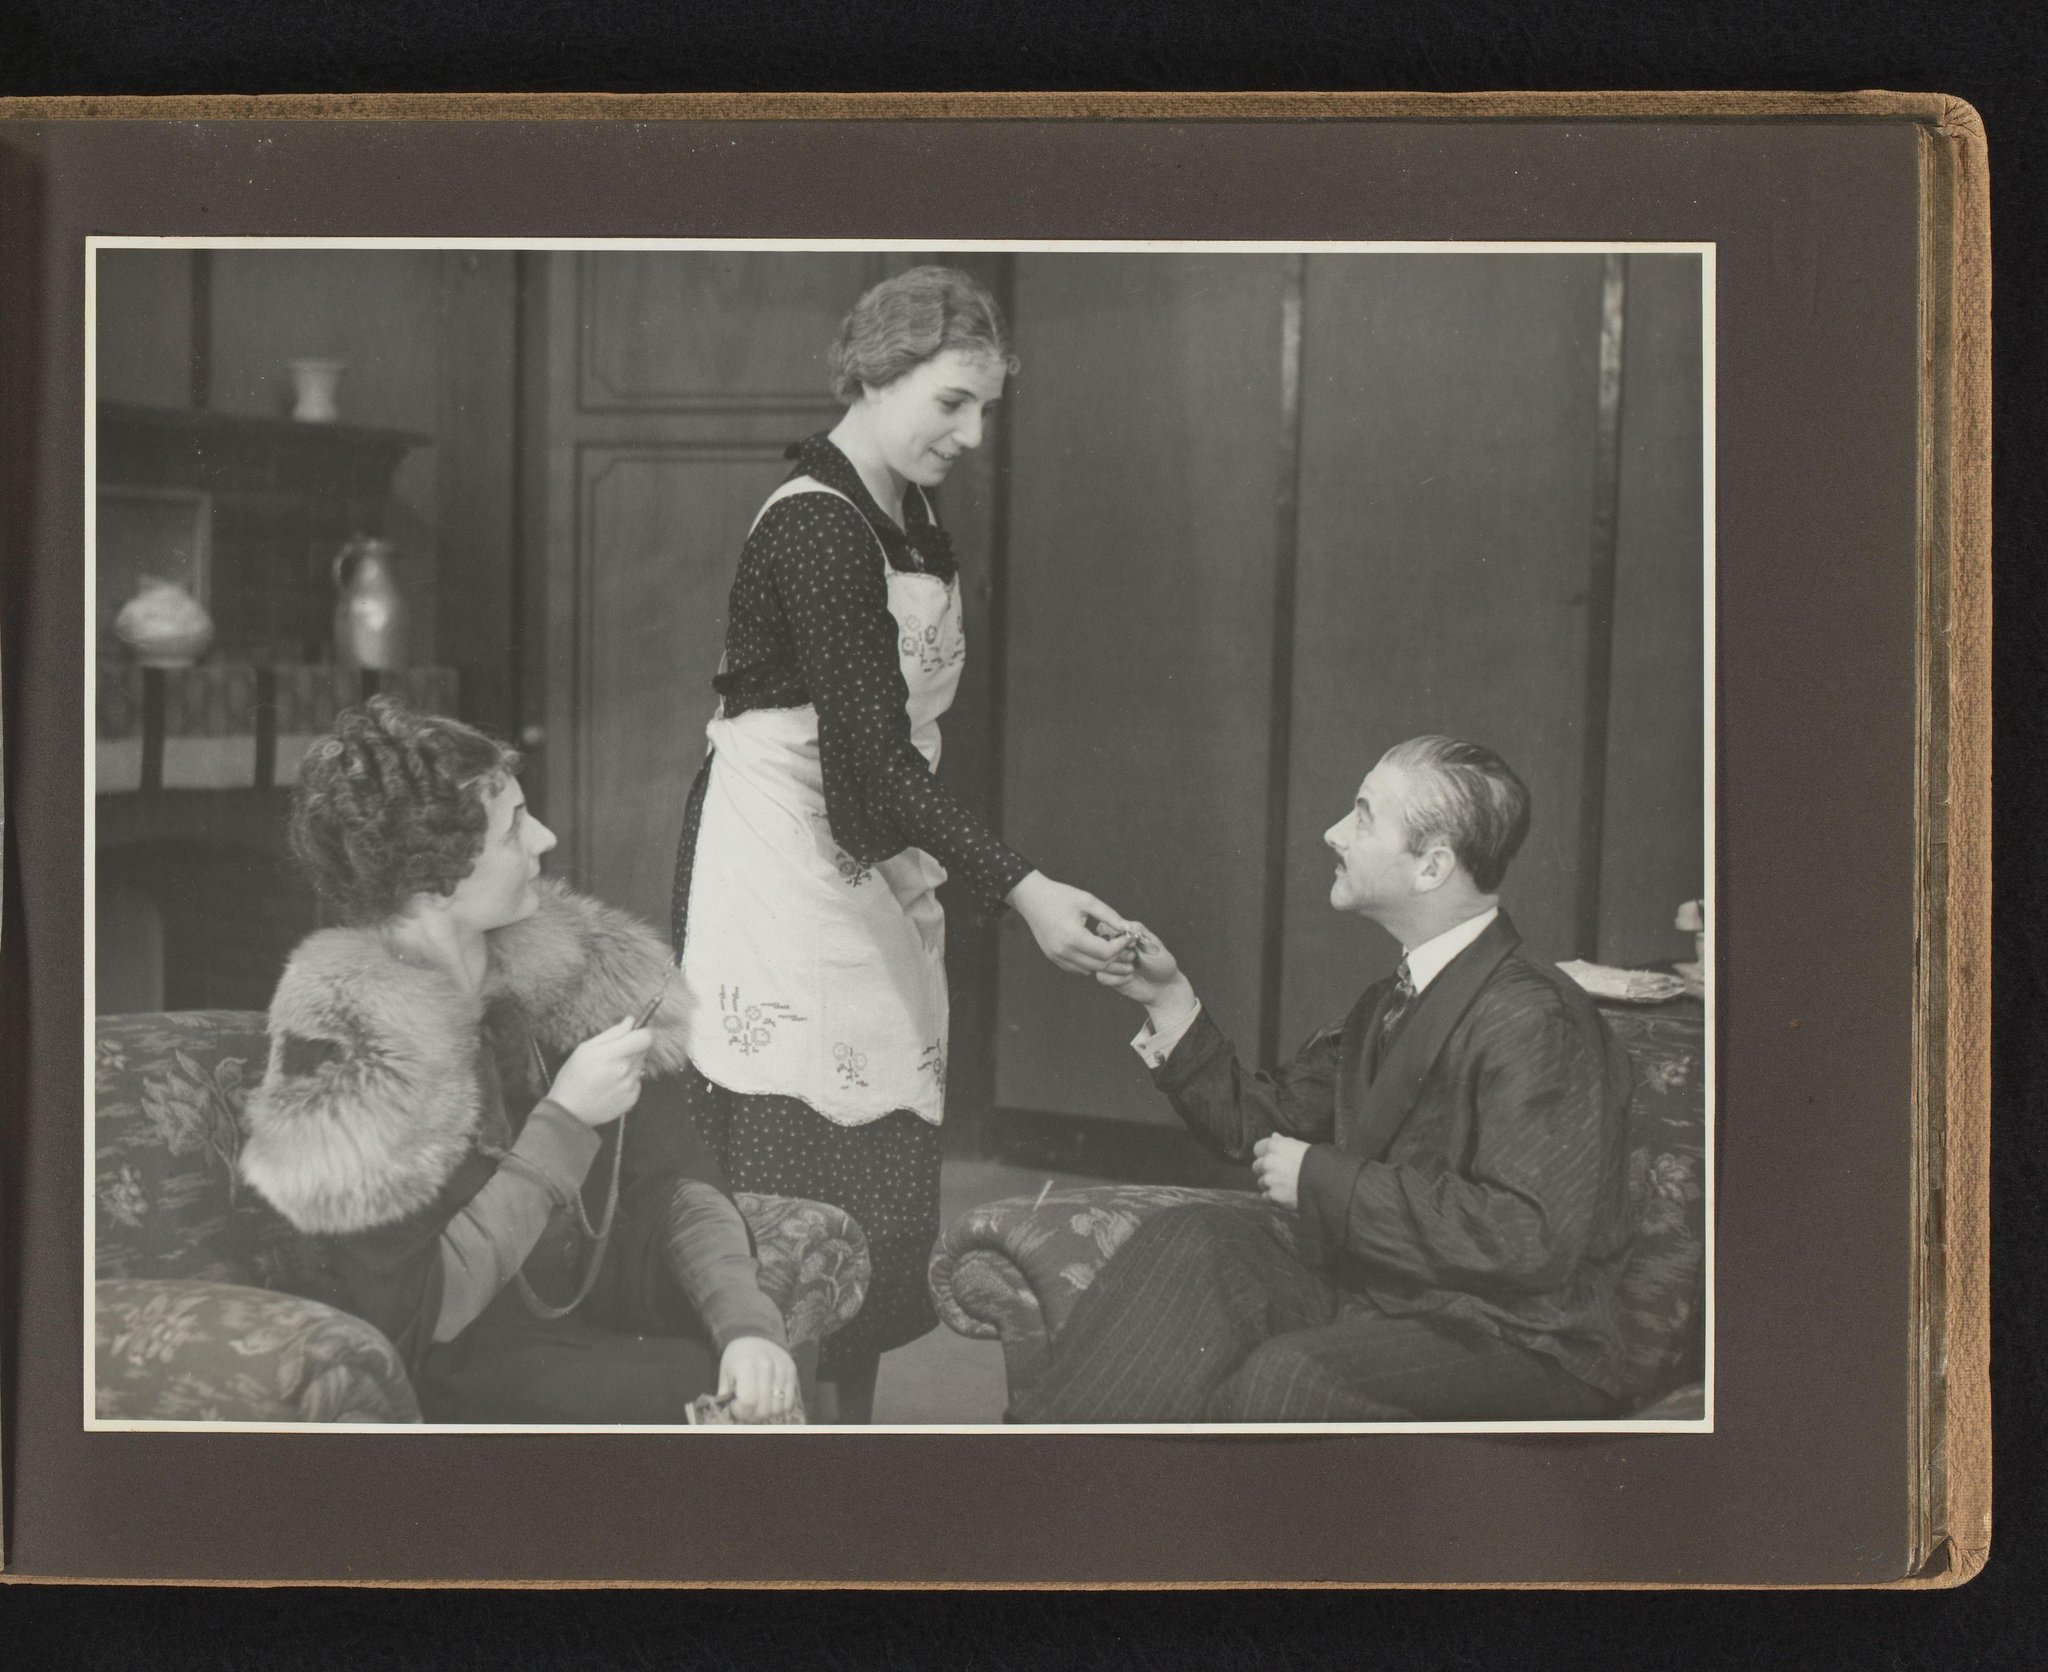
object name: photograph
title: Een scène uit het toneelstuk 'Wat Jonas overkwam'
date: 1936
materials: paper, photographic support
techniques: gelatin silver print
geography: haarlem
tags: theatre, theatrical performance, students' organization, vocational education, e.g.: junior technical school, haarlem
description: Albumblad met een foto van een scène uit de opvoering van het toneelstuk 'Wat Jonas overkwam' op 22 februari 1936. Scène met een man en twee vrouwen. Onderdeel van het fotoalbum 'Jaarfeesten van het Corps M.T.S. te Haarlem'.